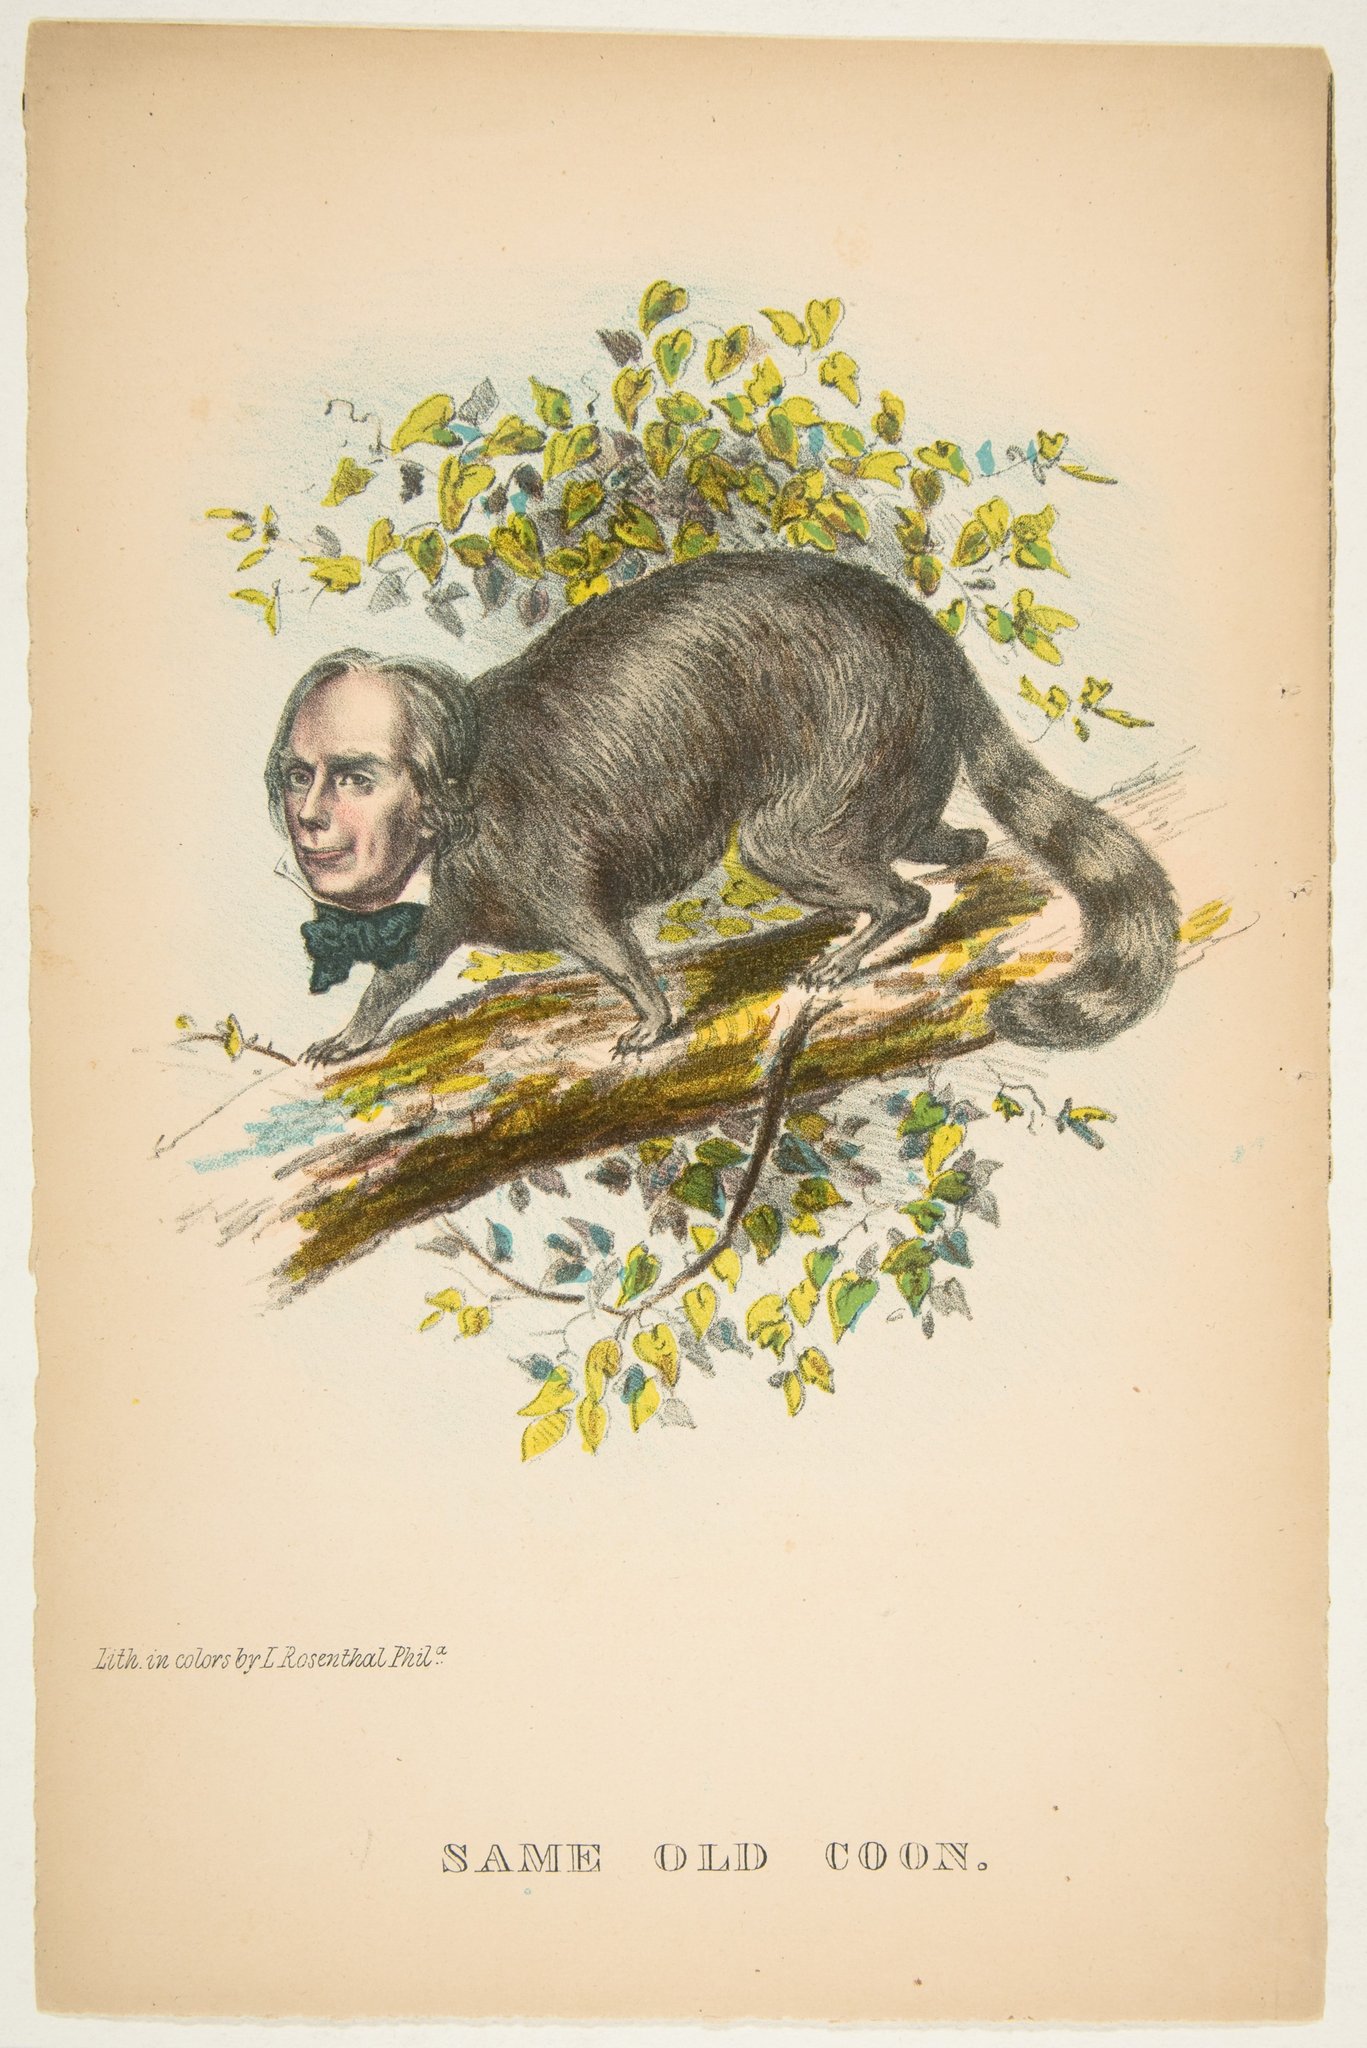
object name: print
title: Same Old Coon (Henry Clay), from "The Comic Natural History of the Human Race"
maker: henry louis stephens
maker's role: artist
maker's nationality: american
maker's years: 1824-1882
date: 1851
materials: watercolor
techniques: lithograph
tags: satire,leaves